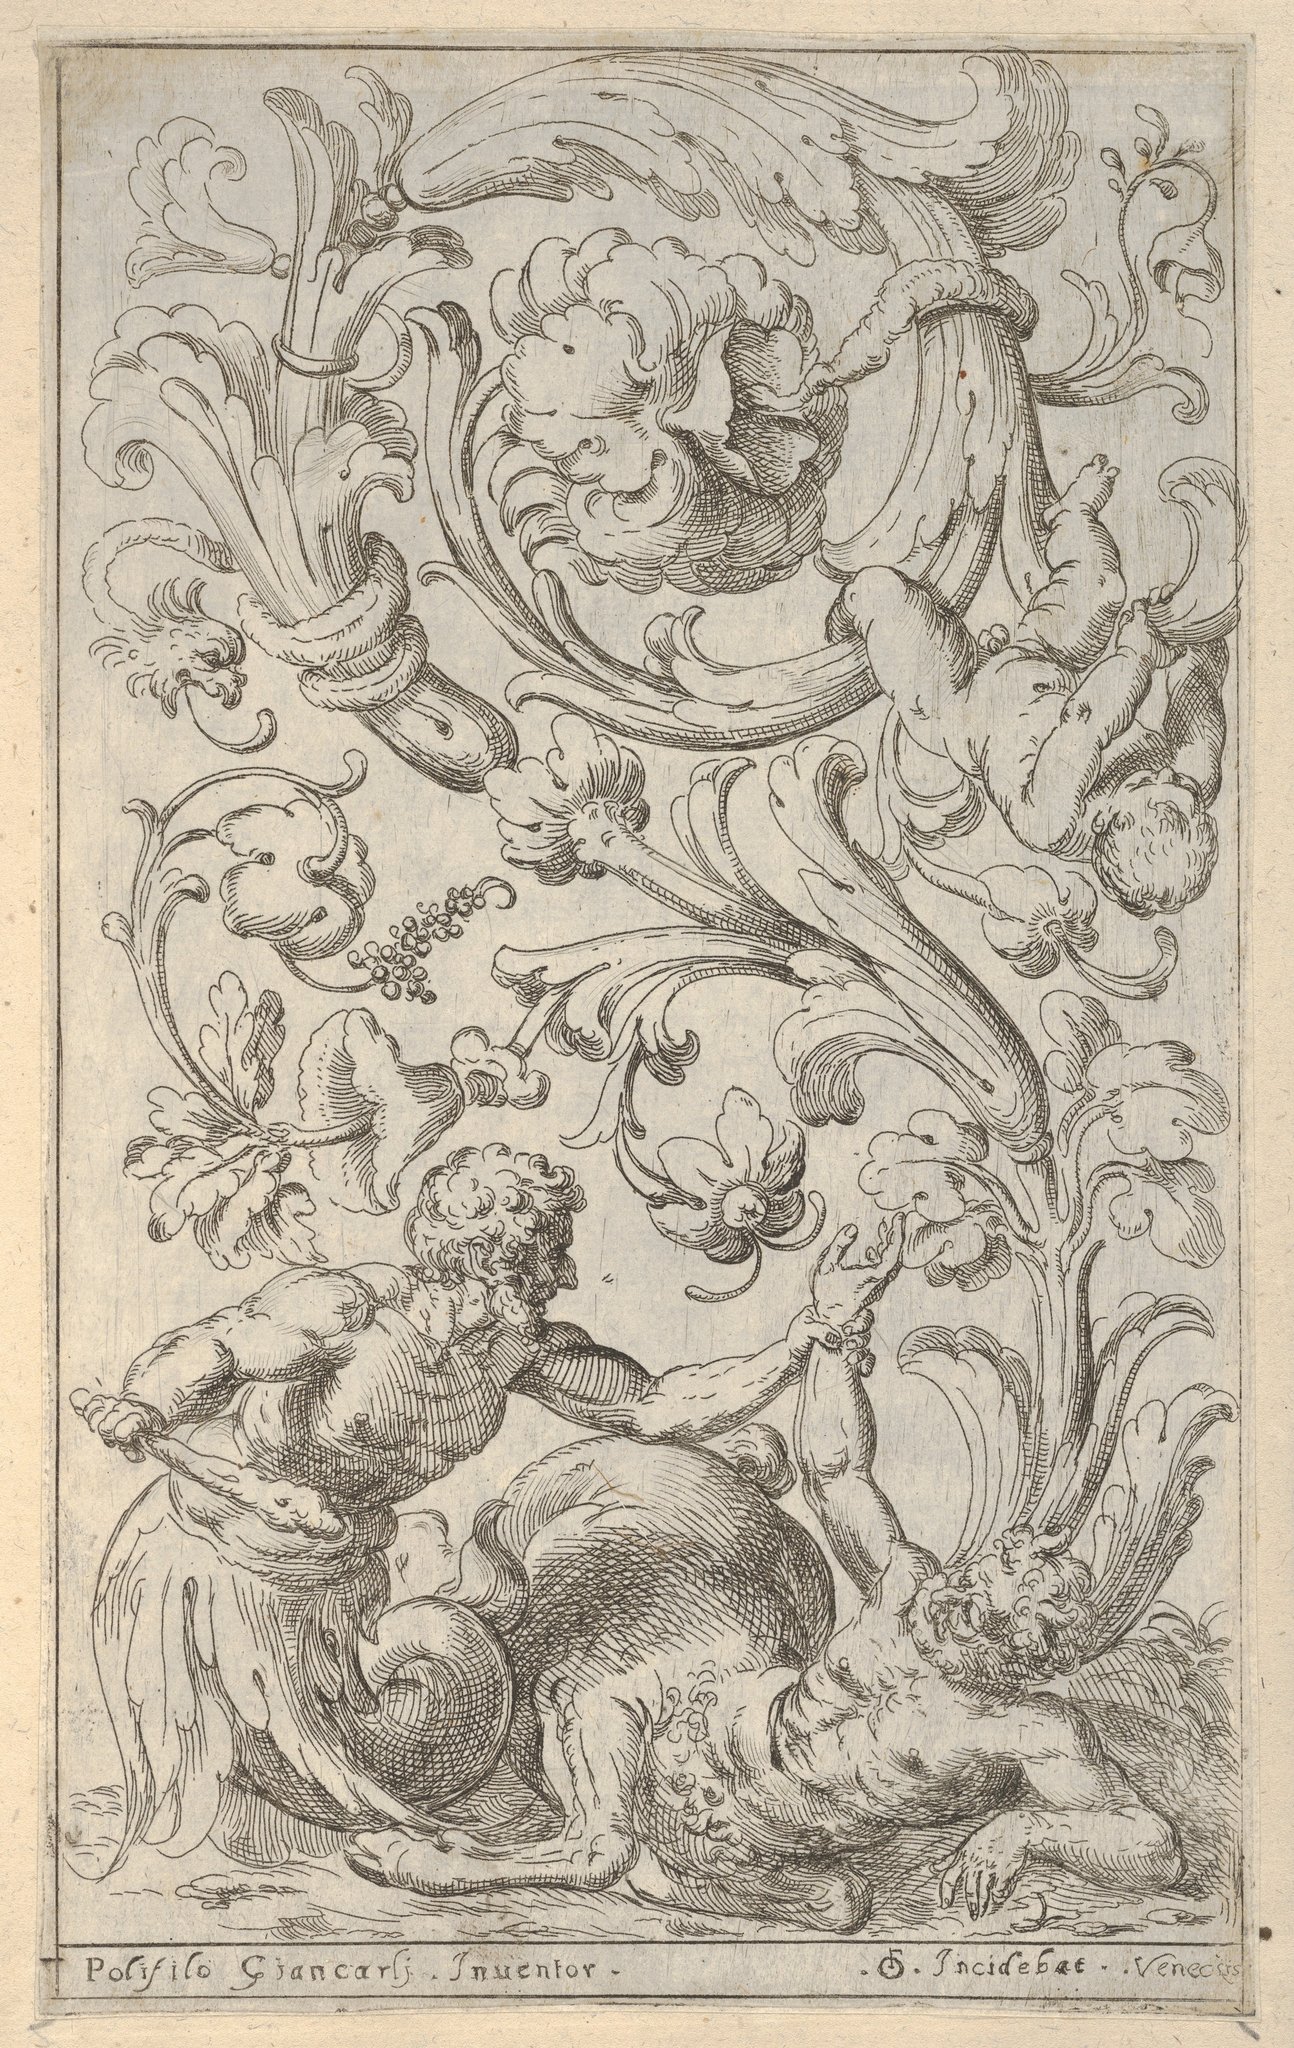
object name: collection ornament architecture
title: Disegni Varii di Polifilo Zancarli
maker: polifilo giancarli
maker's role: artist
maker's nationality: italian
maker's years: 1600-1625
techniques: etching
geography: italy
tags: centaurs,acanthus